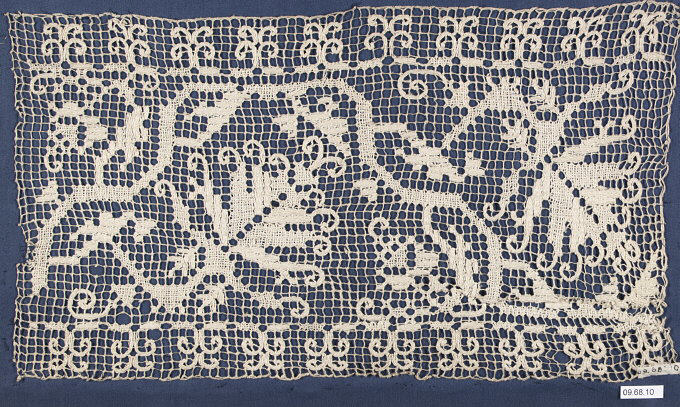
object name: border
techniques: embroidery